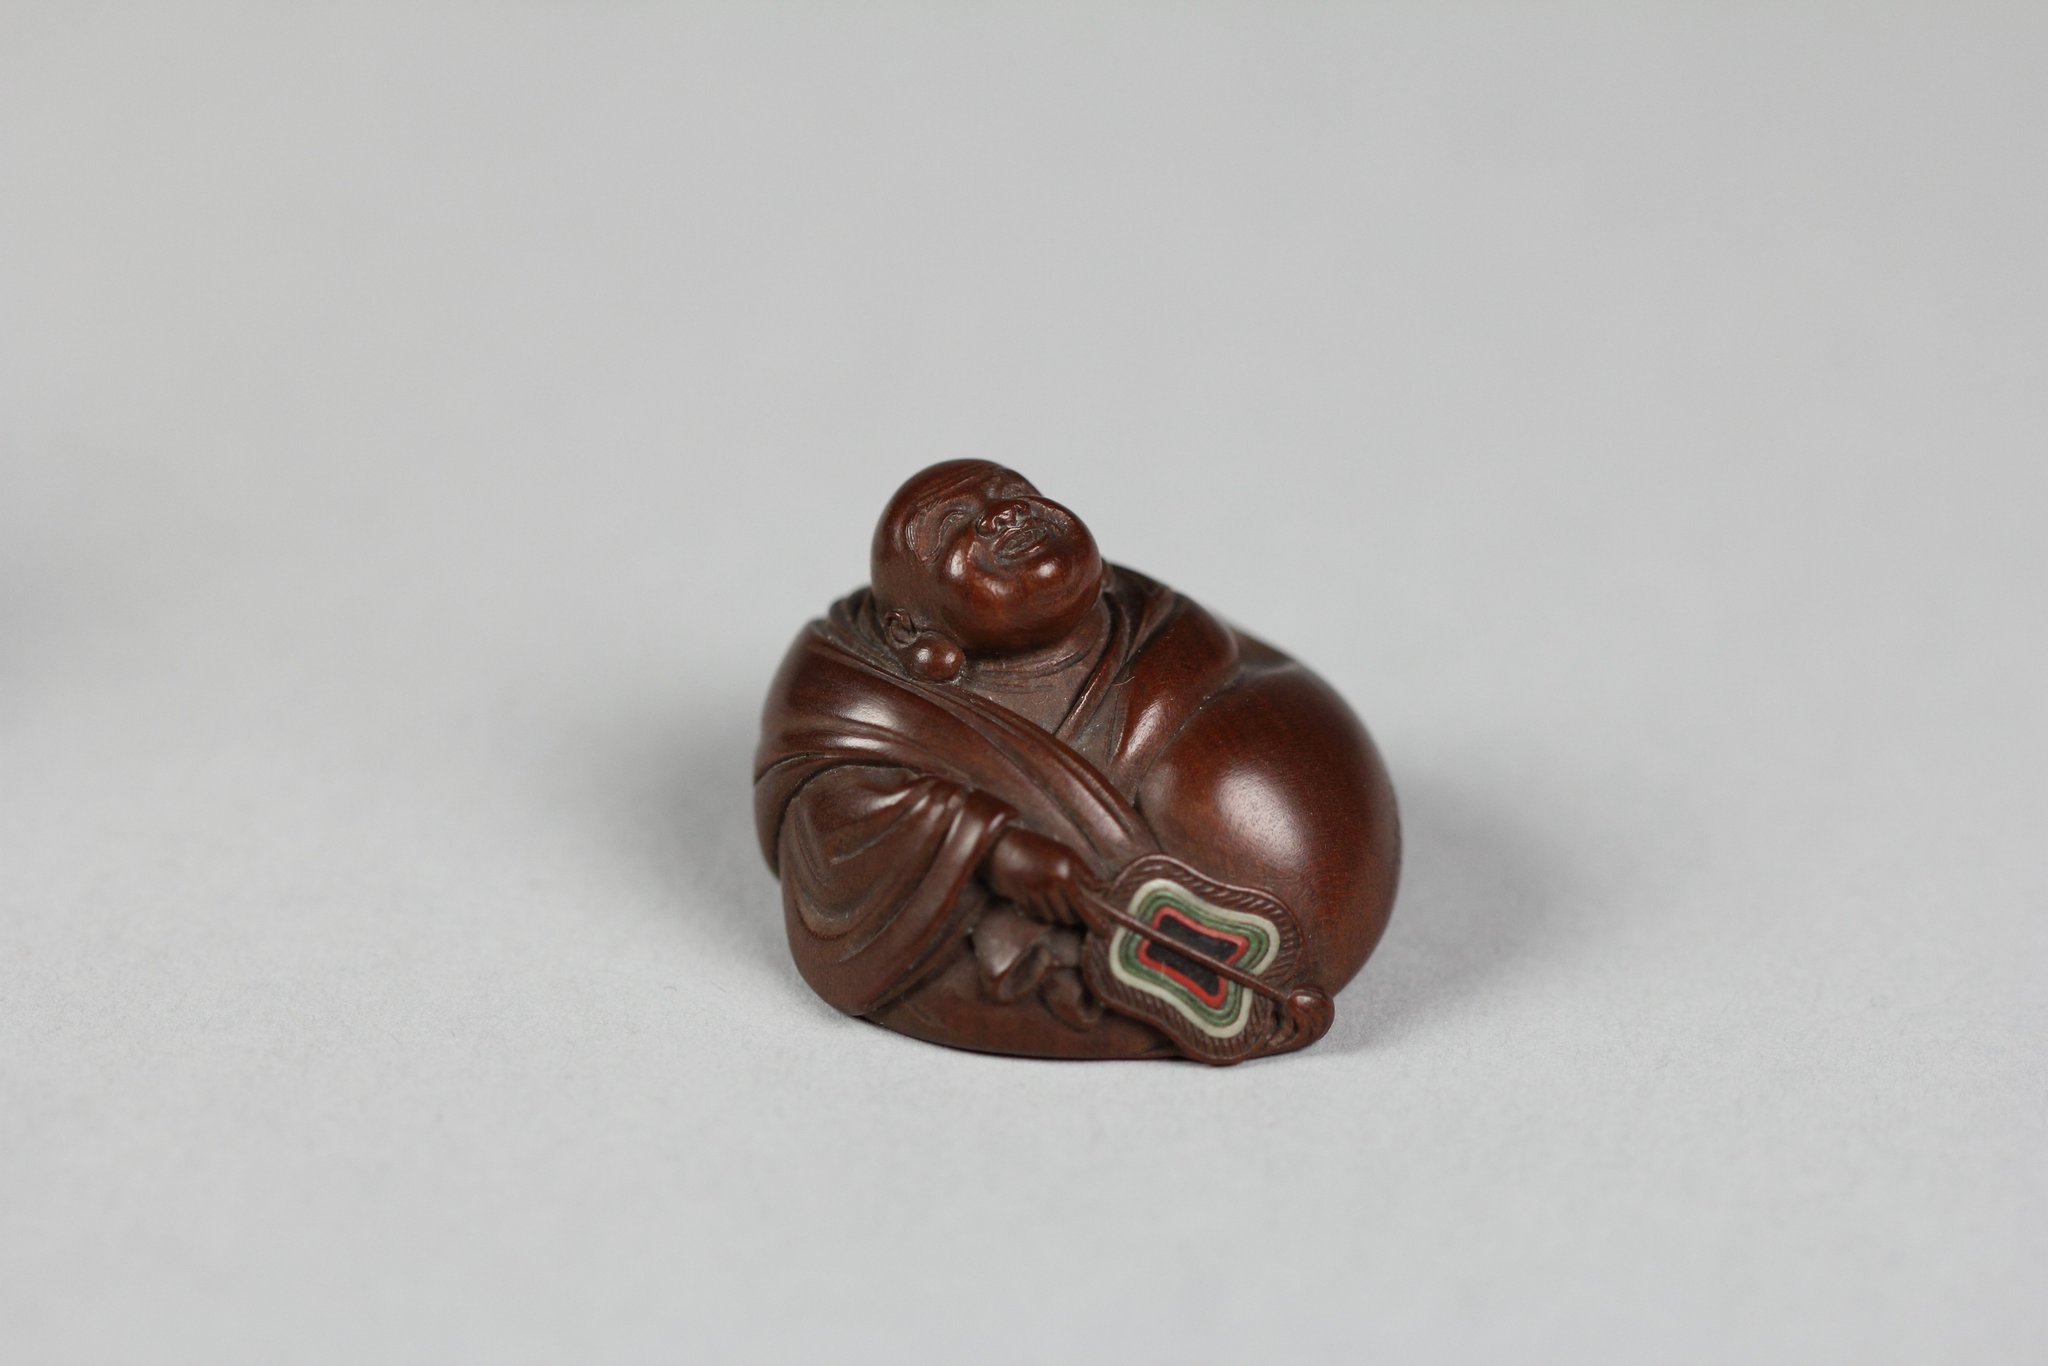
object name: netsuke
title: Netsuke of Hotei and Bag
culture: japanese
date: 1801-1900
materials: wood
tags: men